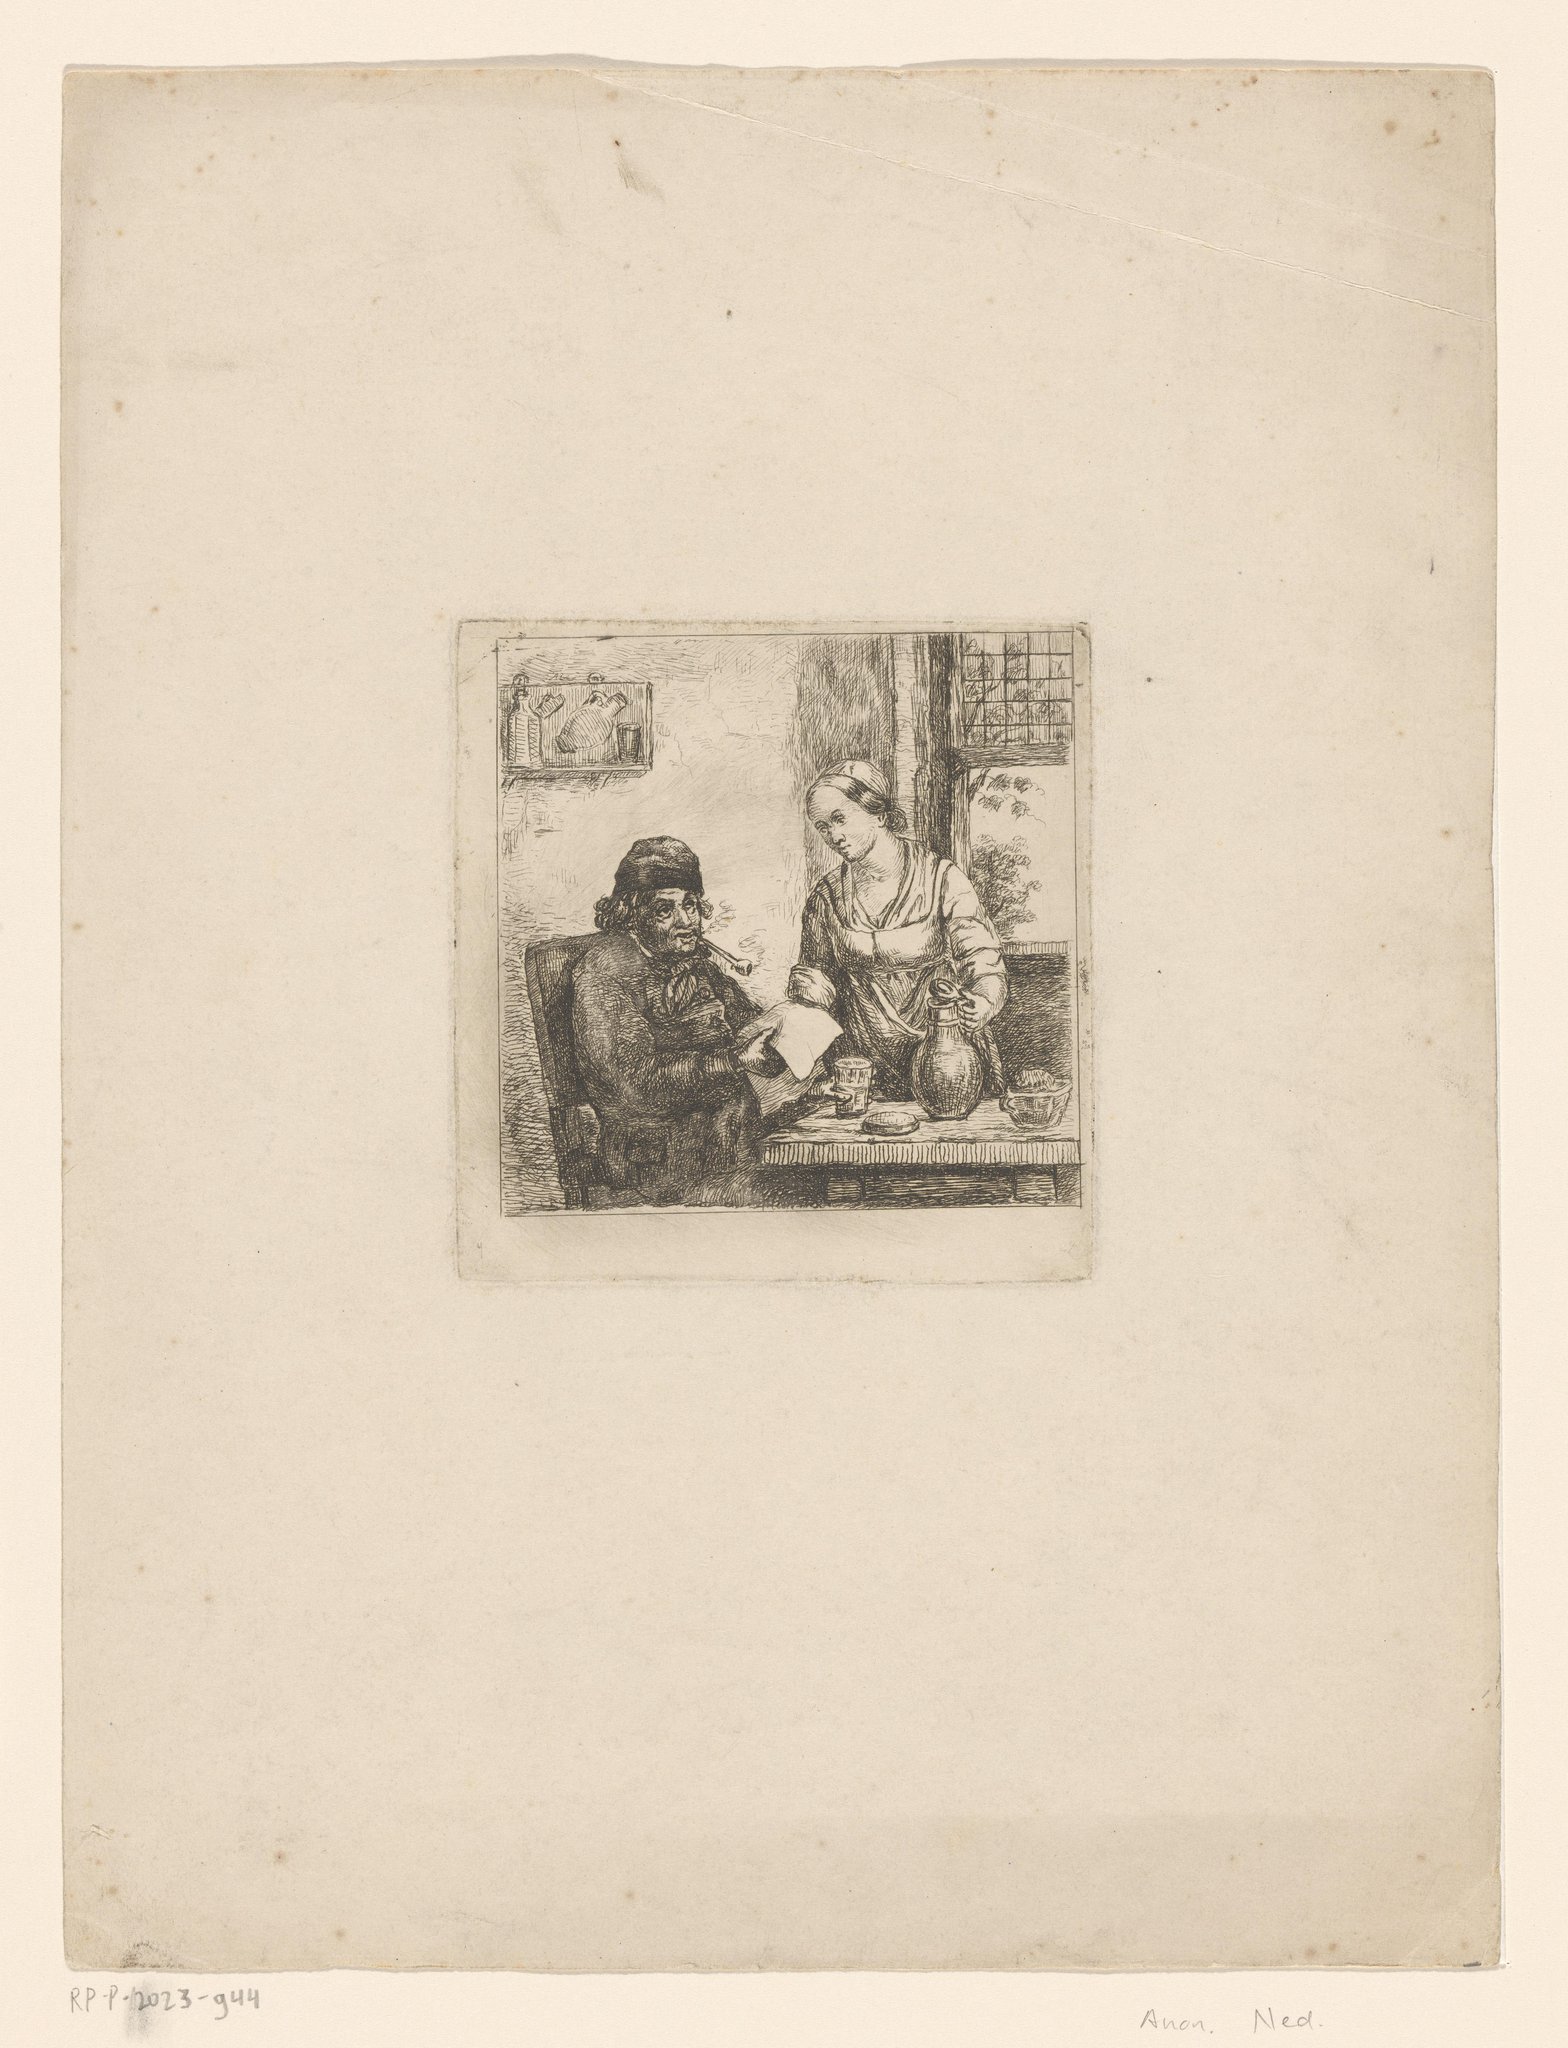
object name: print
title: Pijprokende man en vrouw met kan bij een tafel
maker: Anonymous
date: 1650-1799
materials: paper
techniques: etching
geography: low countries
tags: pipe ~ tobacco (+ taking (particular) foodstuffs: eating, drinking, smoking, chewing, etc.), container of ceramics: jar, jug, pot, vase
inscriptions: collector's mark: Lugt 2228